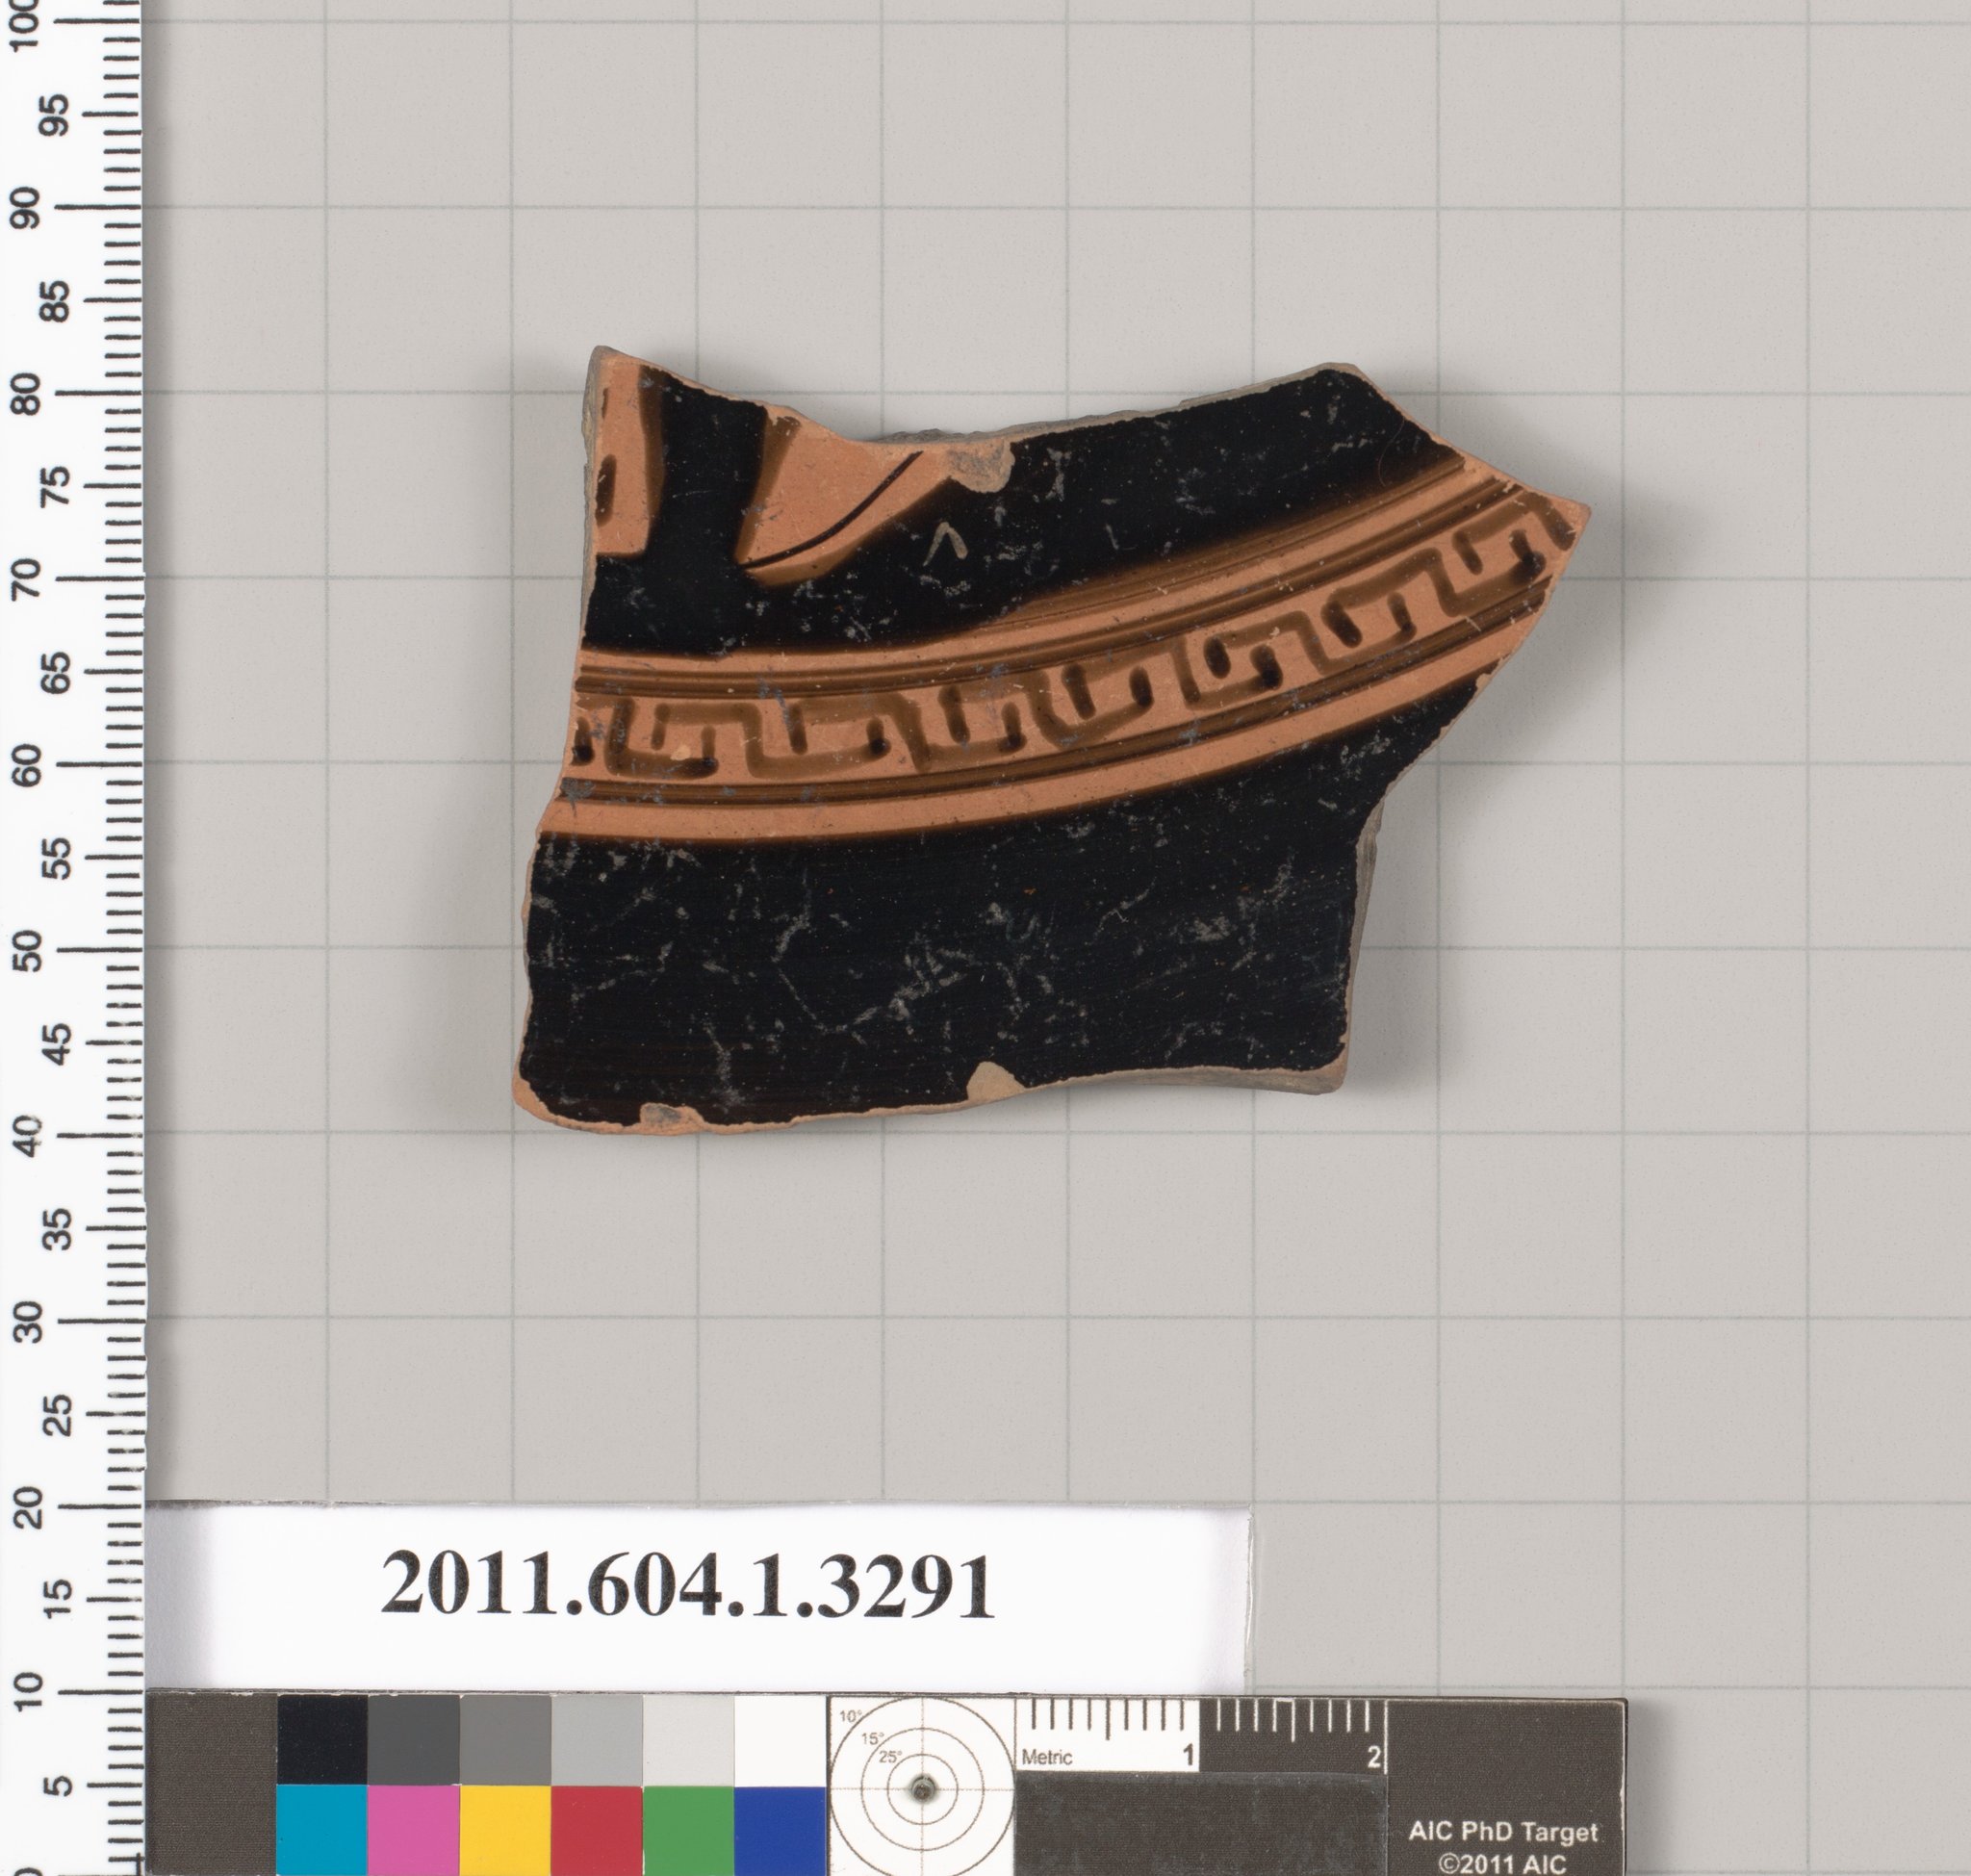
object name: kylix fragment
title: Terracotta fragment of a kylix (drinking cup)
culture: greek, attic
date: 475-451 BCE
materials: terracotta